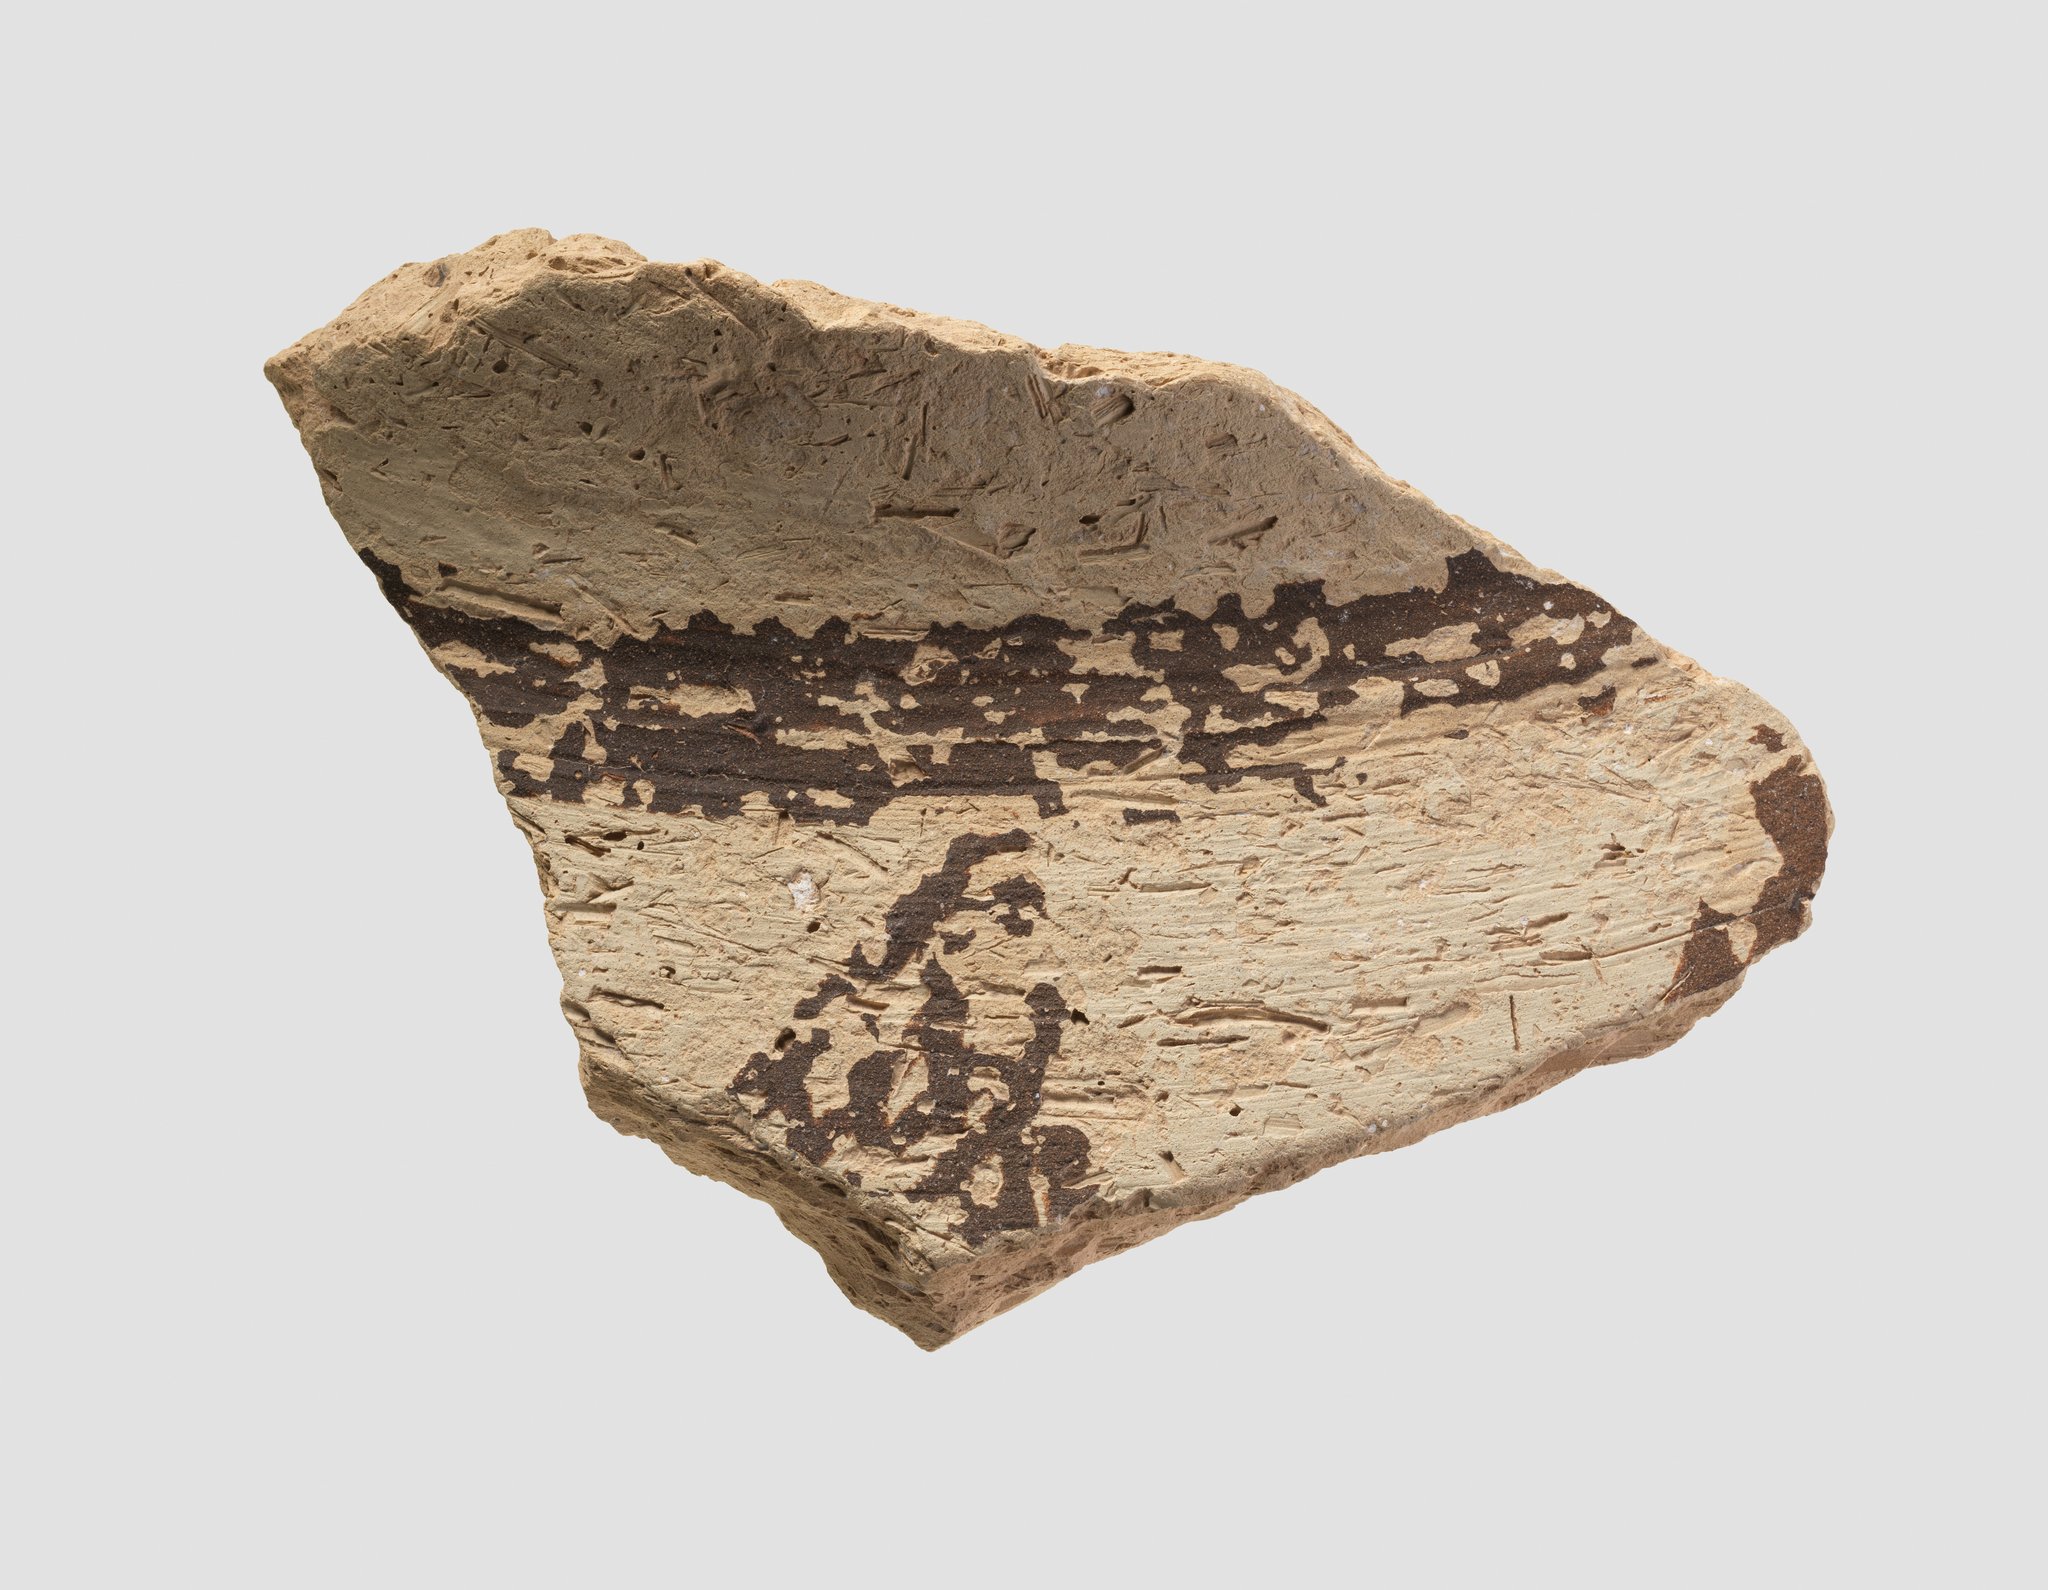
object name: sherd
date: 2000-1668 BCE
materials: ceramic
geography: mesopotamia